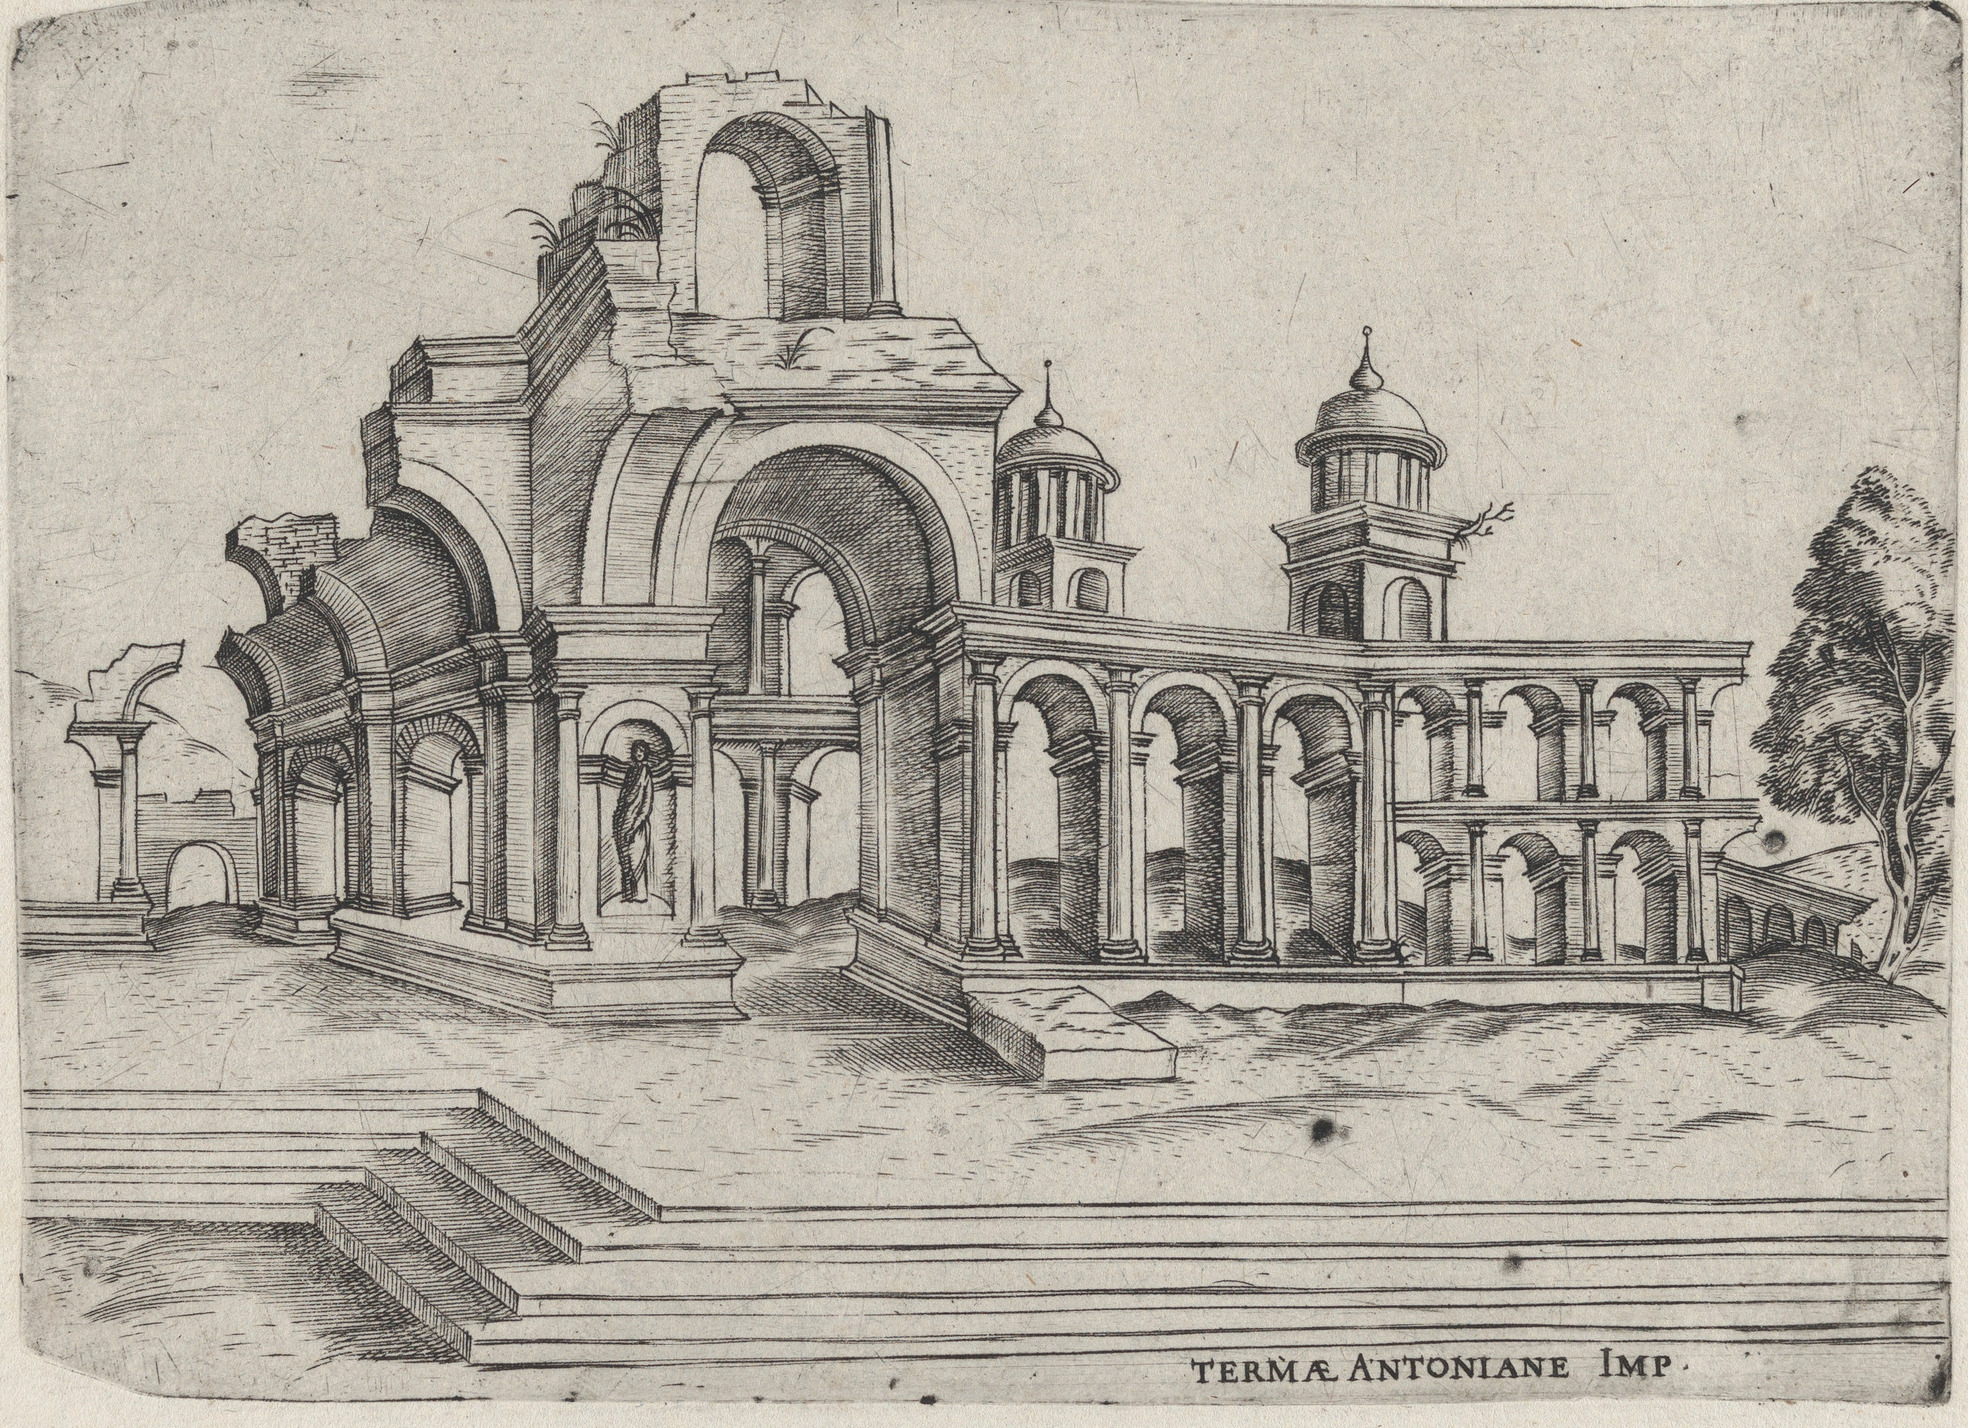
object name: print ornament architecture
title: Termae Antoniane Imp. [formerly Palatium Se Lugduni], from a Series of 24 Depicting (Reconstructed) Buildings from Roman Antiquity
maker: anonymous, italian, 16th century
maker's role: artist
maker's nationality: italian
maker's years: 1500-1600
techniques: engraving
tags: architecture,buildings